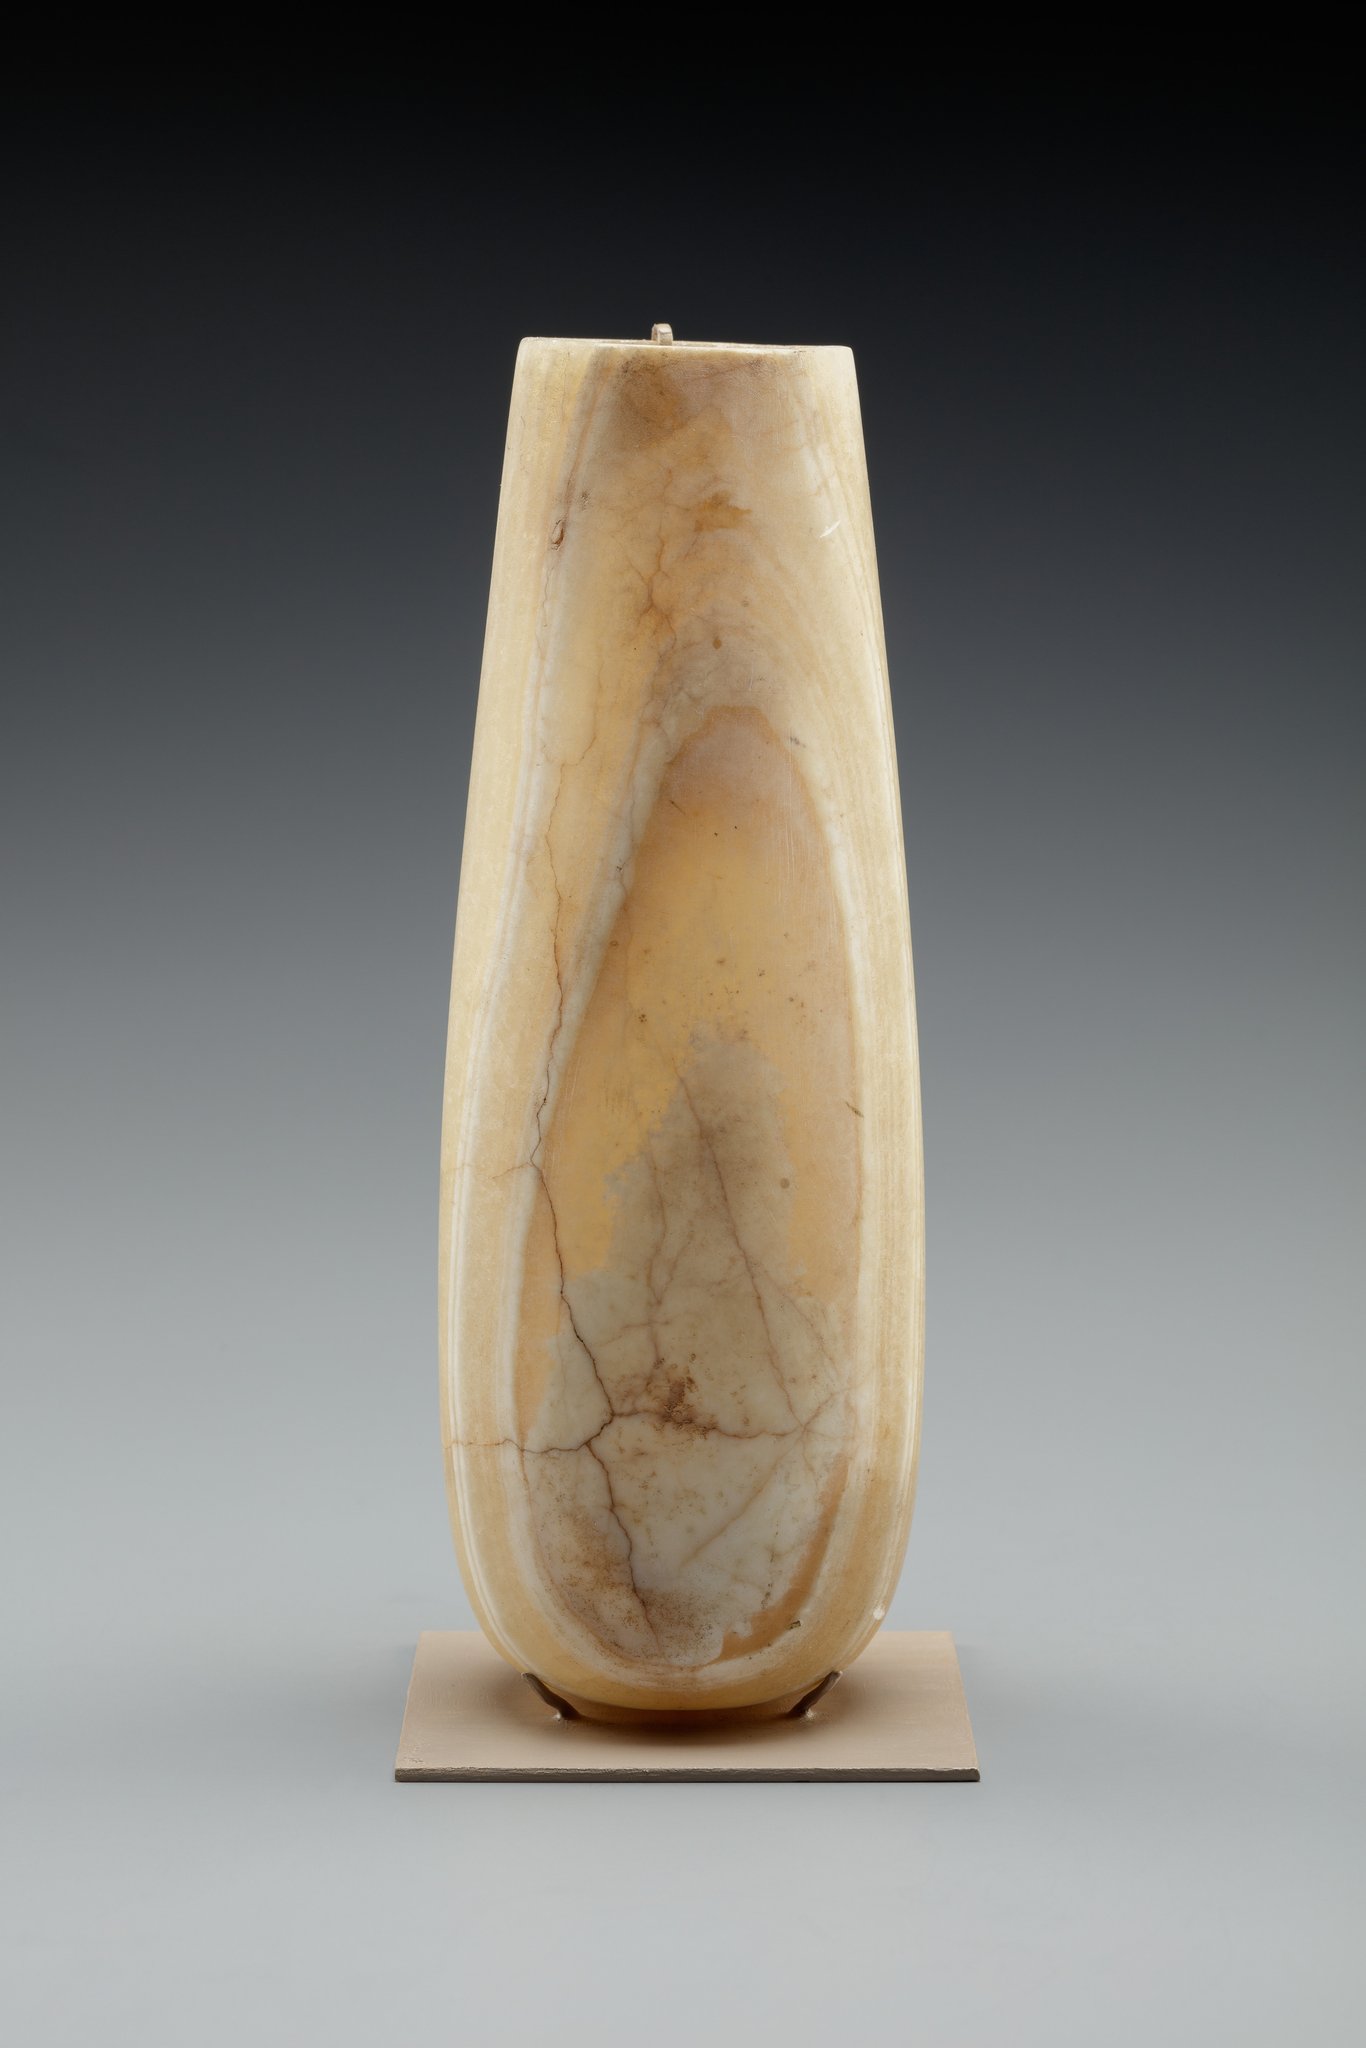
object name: vase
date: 664-332 BCE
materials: stone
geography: egypt